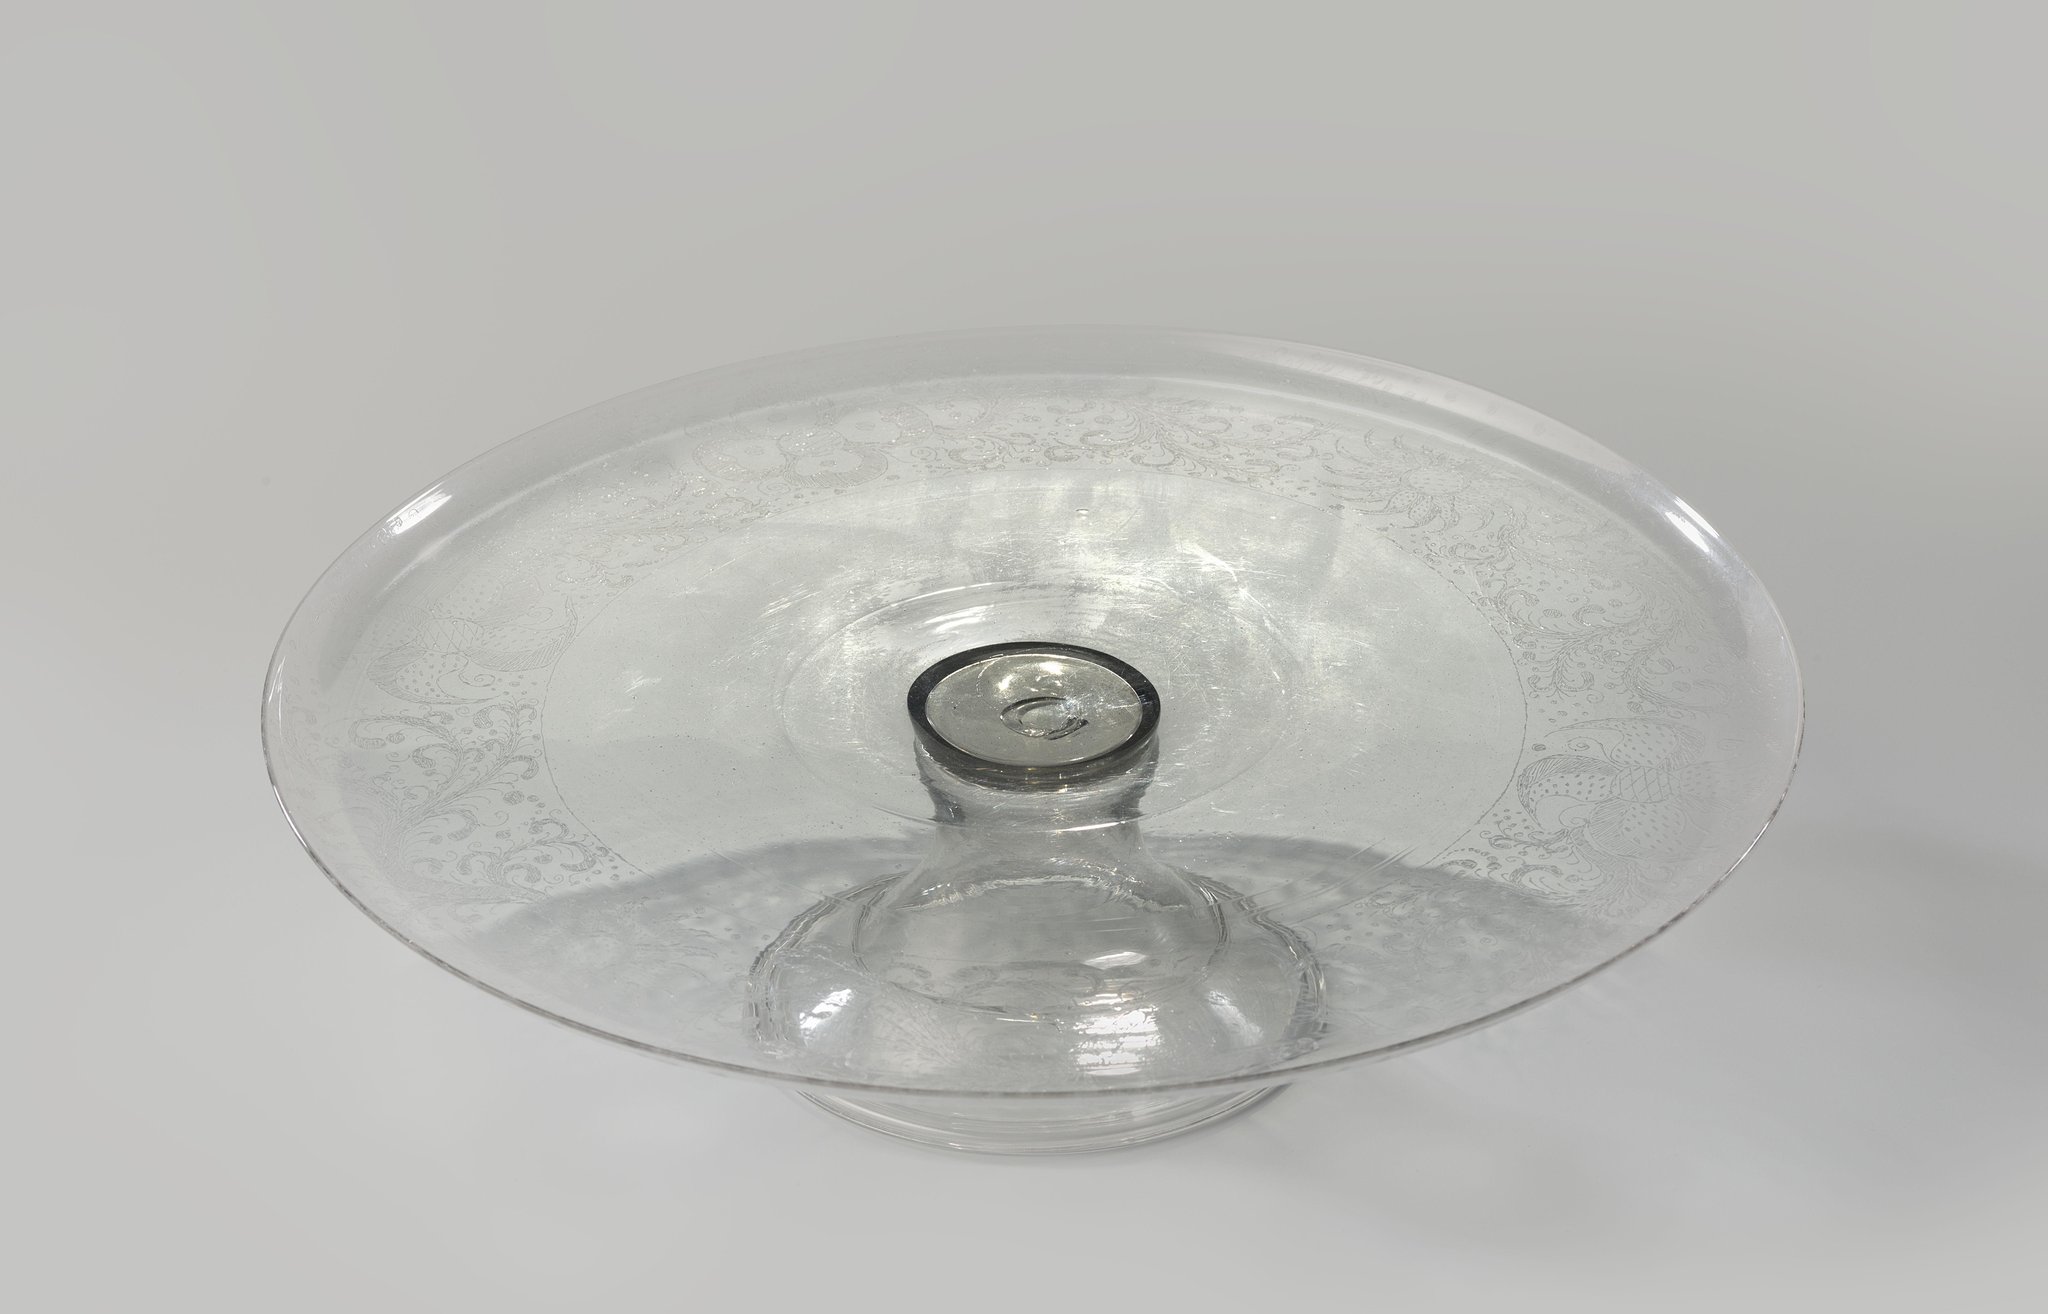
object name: tazza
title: Tazza met diamantgravure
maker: Anonymous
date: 1550-1600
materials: glass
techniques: diamond point engraving, façon de venise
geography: venice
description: Tazza met klokvormige voet met ongeslagen rand, overgaande in een licht gebogen stam. Platte wijde kelk met een licht naar boven gebogen rand en gegraveerd met een brede, aan de binnenzijde door een bies afgezette rand van zonnebloemen, rozetten en gestileerde bladranken.